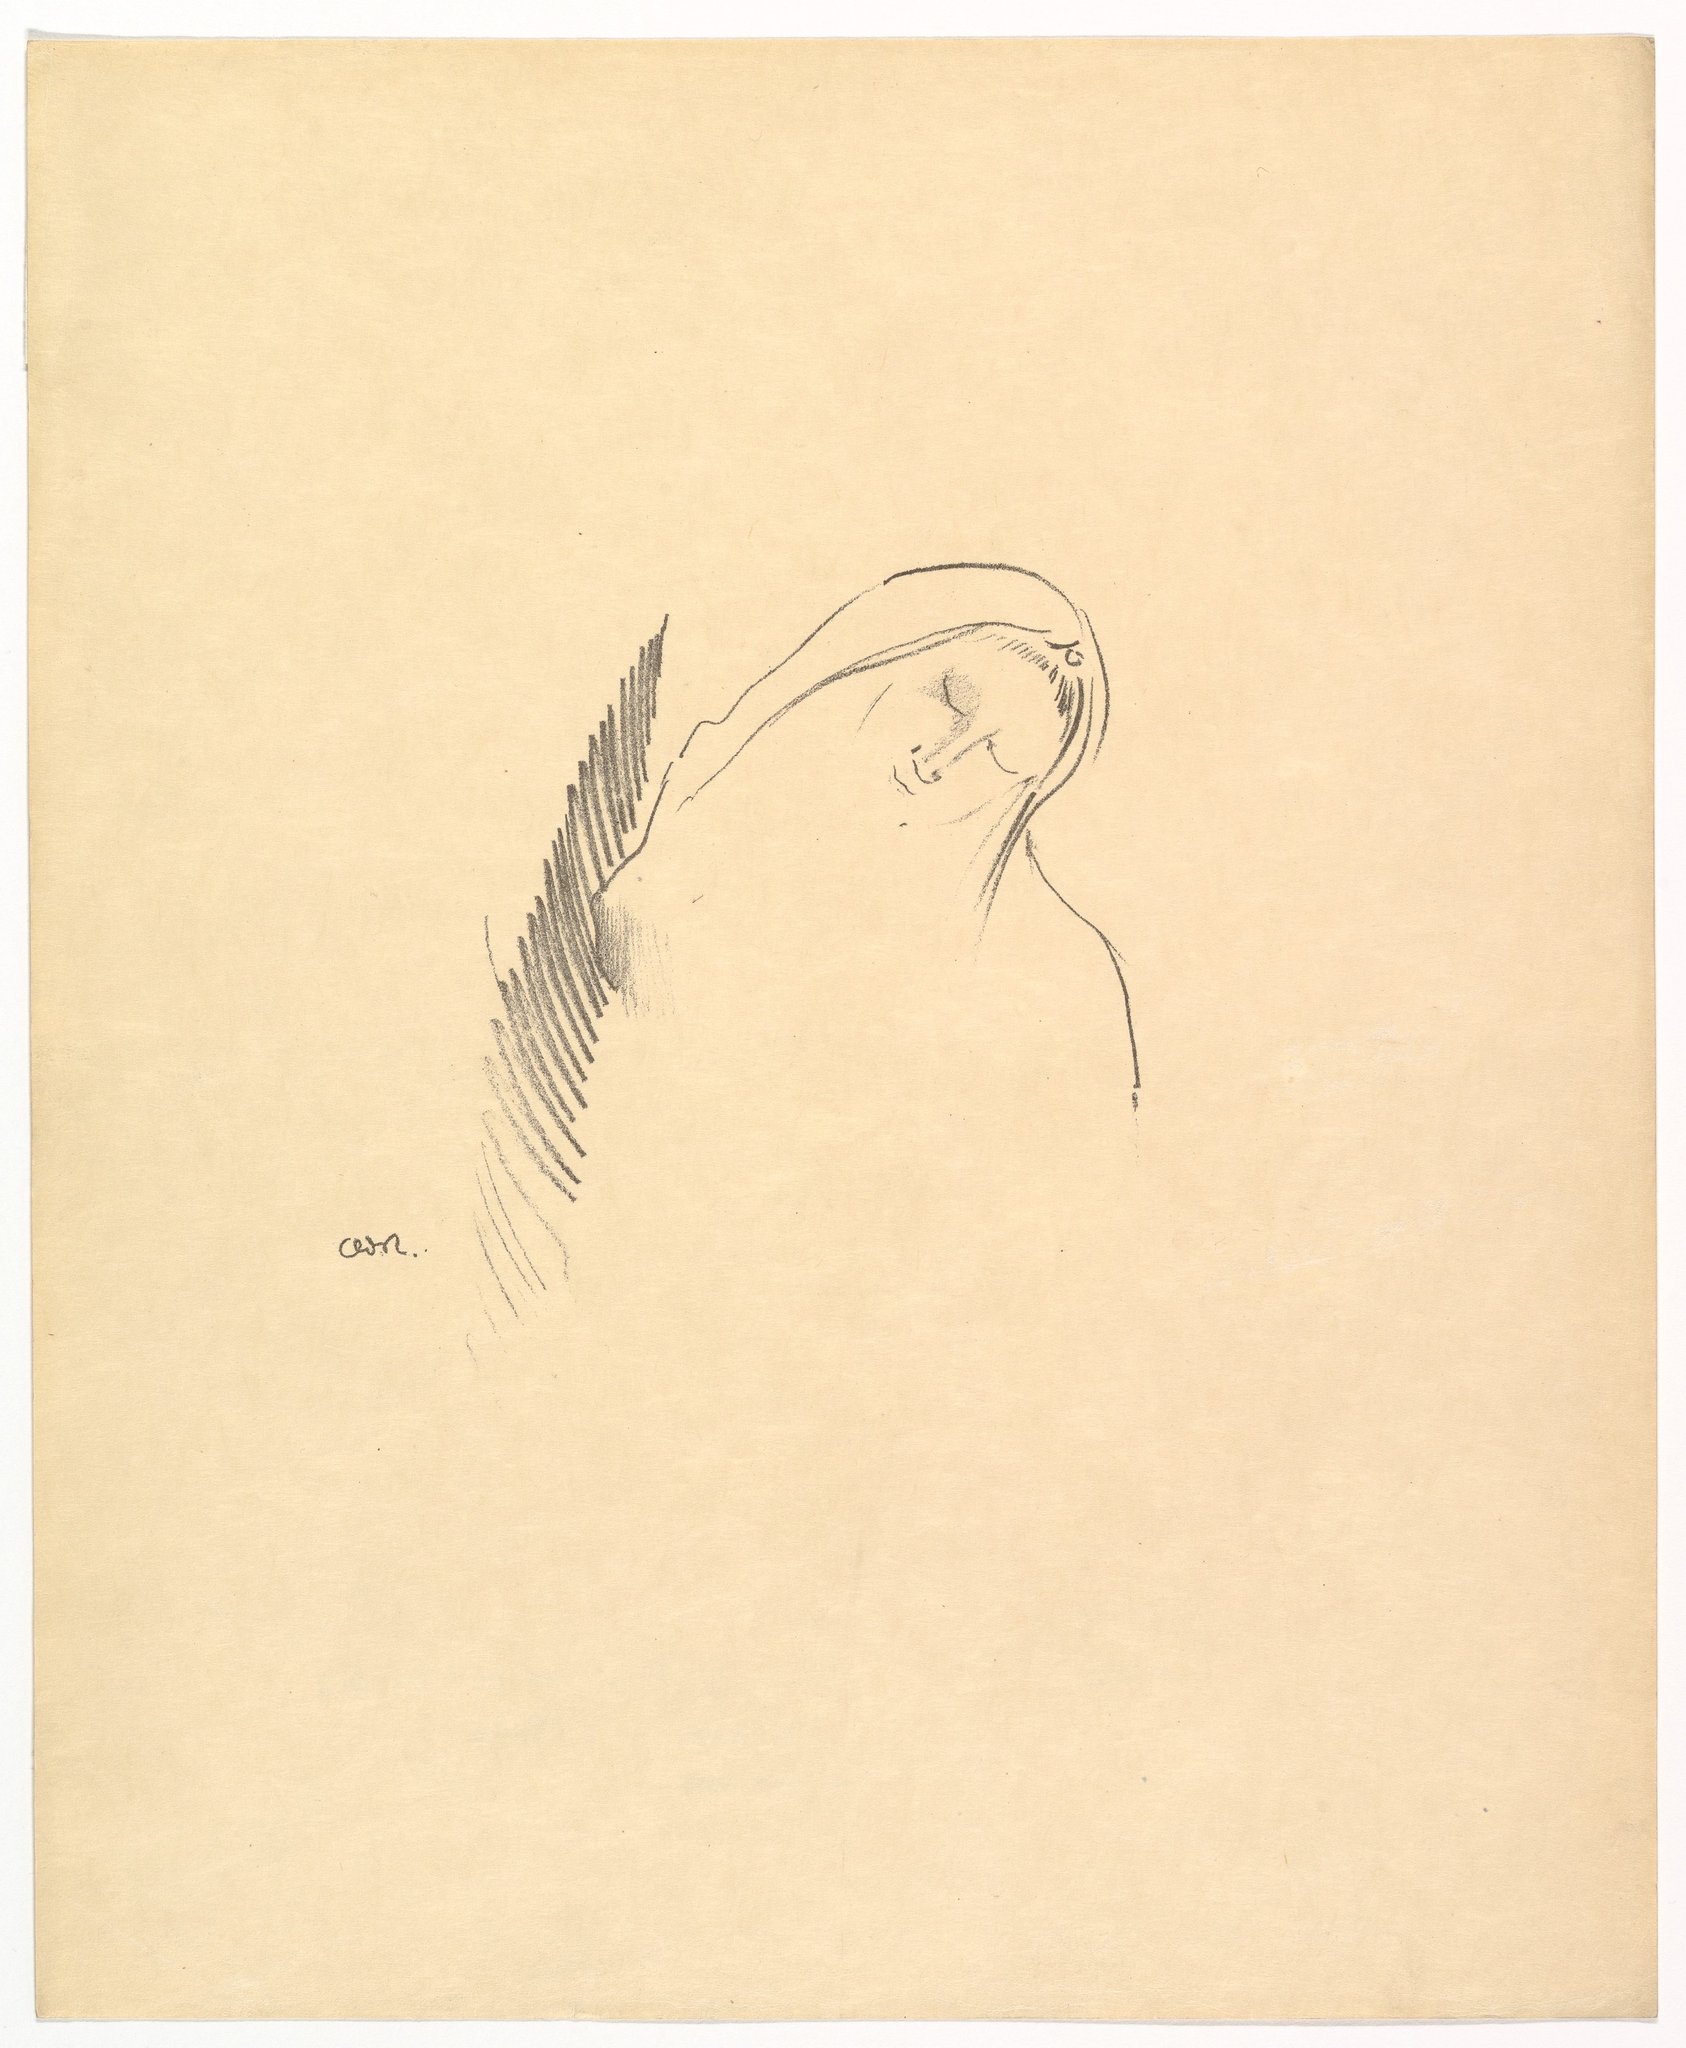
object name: print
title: Sleep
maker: odilon redon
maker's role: artist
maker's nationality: french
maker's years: 1840-1916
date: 1898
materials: paper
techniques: lithograph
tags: sleeping,women